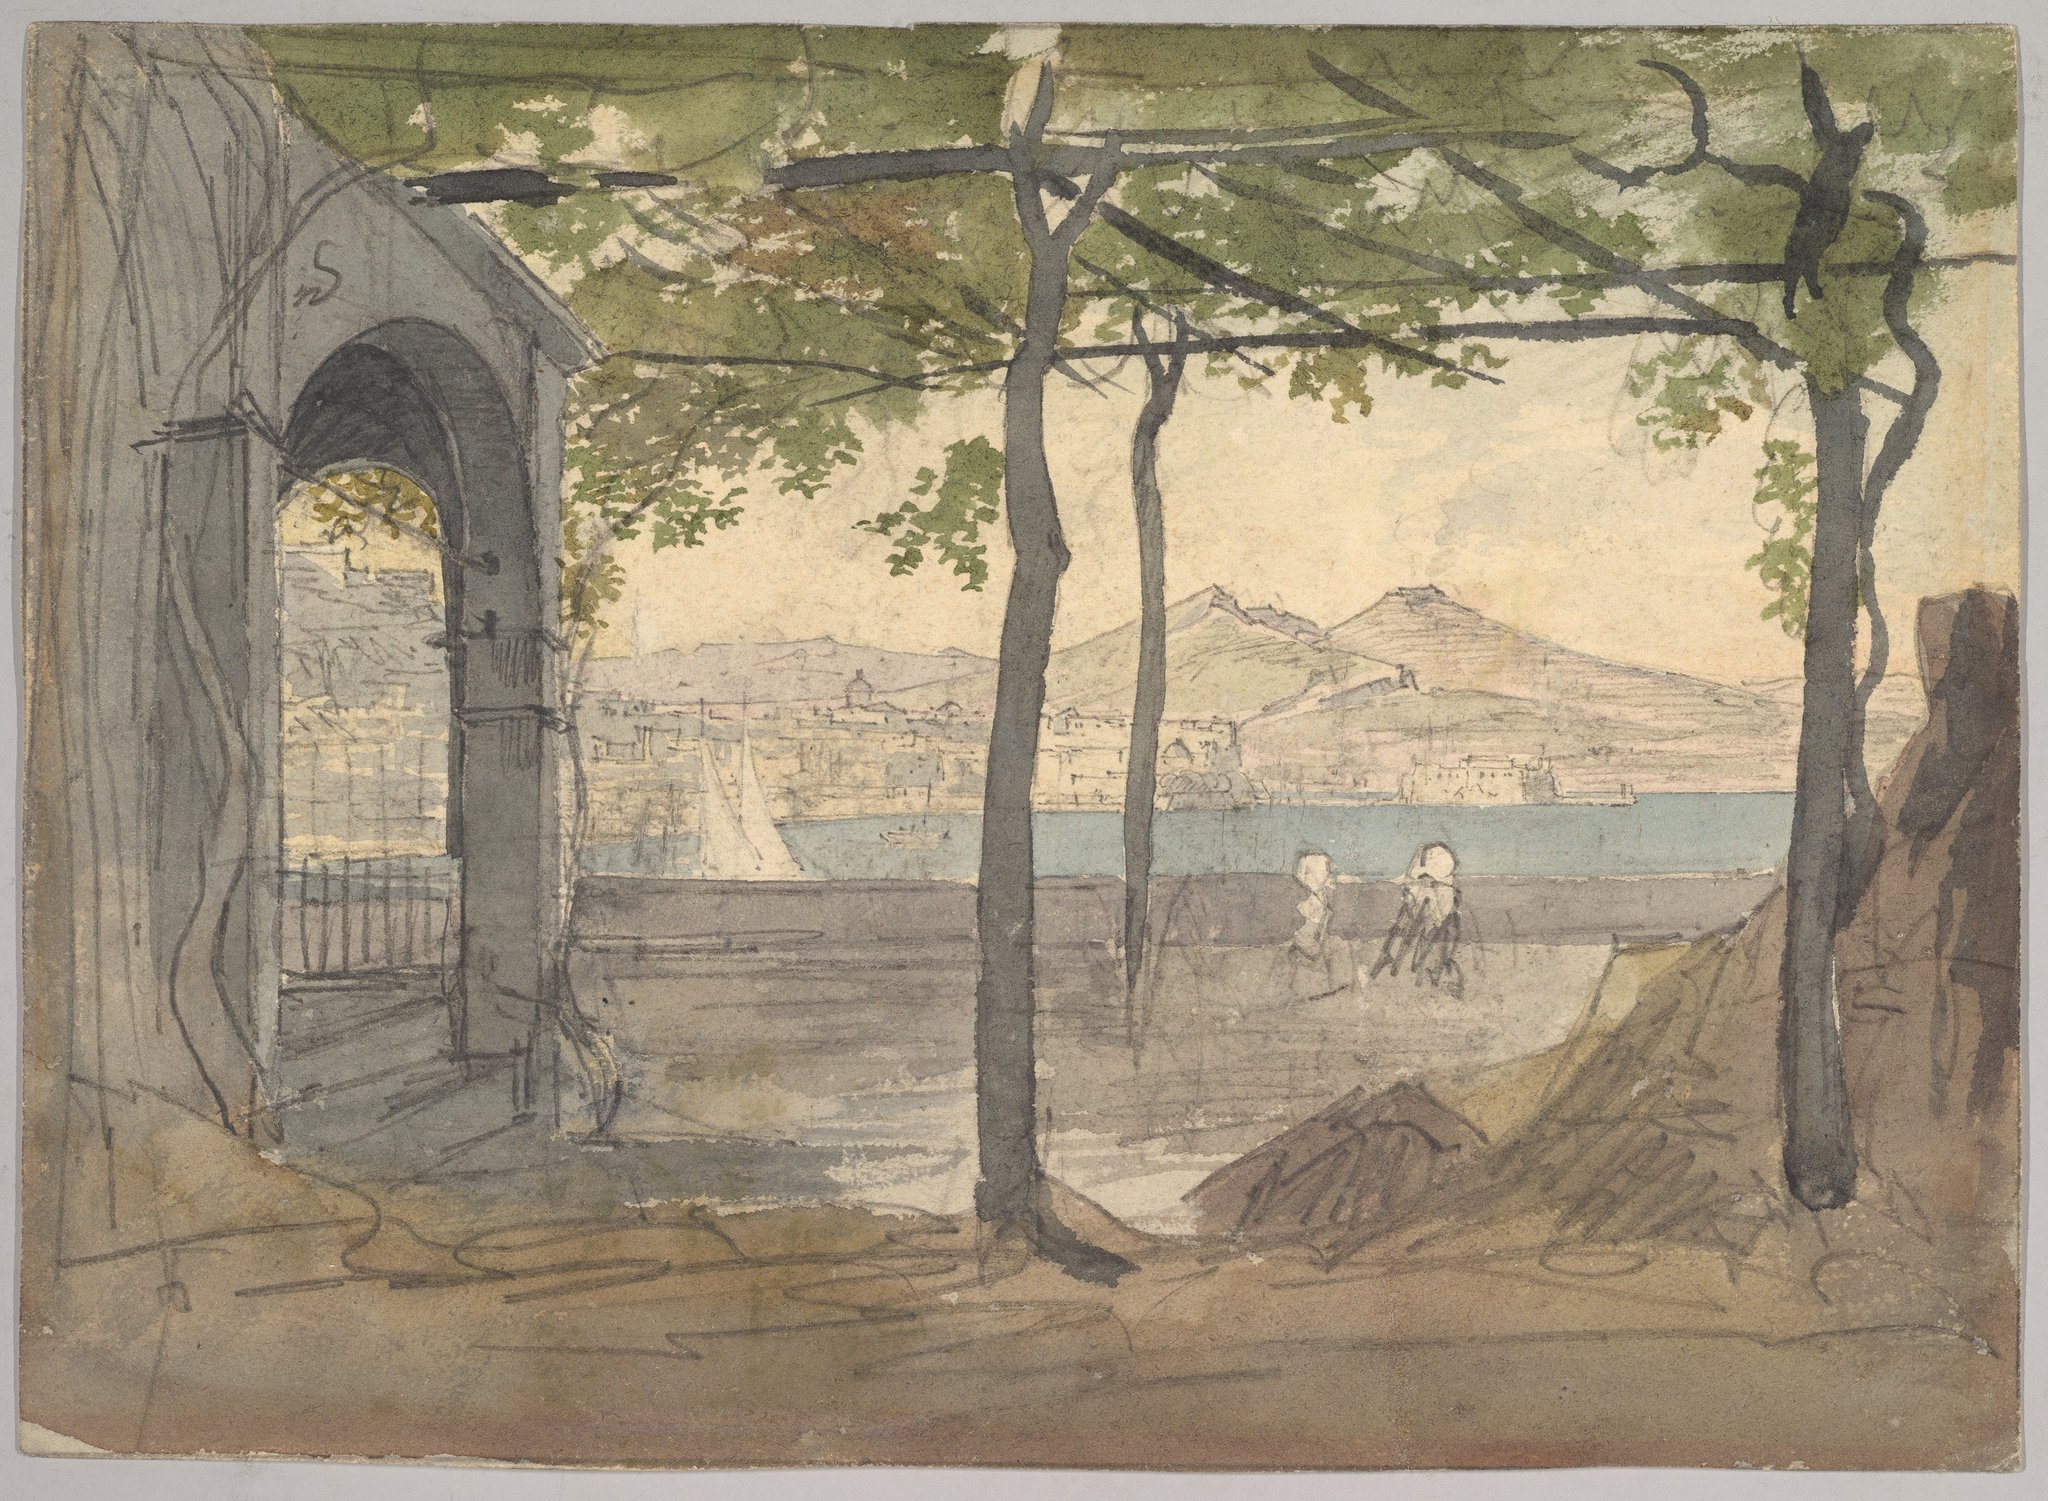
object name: drawing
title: View of the Bay of Naples with Mount Vesuvius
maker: franz ludwig catel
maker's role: artist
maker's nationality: german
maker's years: 1778-1856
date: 1820-1822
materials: graphite, watercolor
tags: mountains,trees